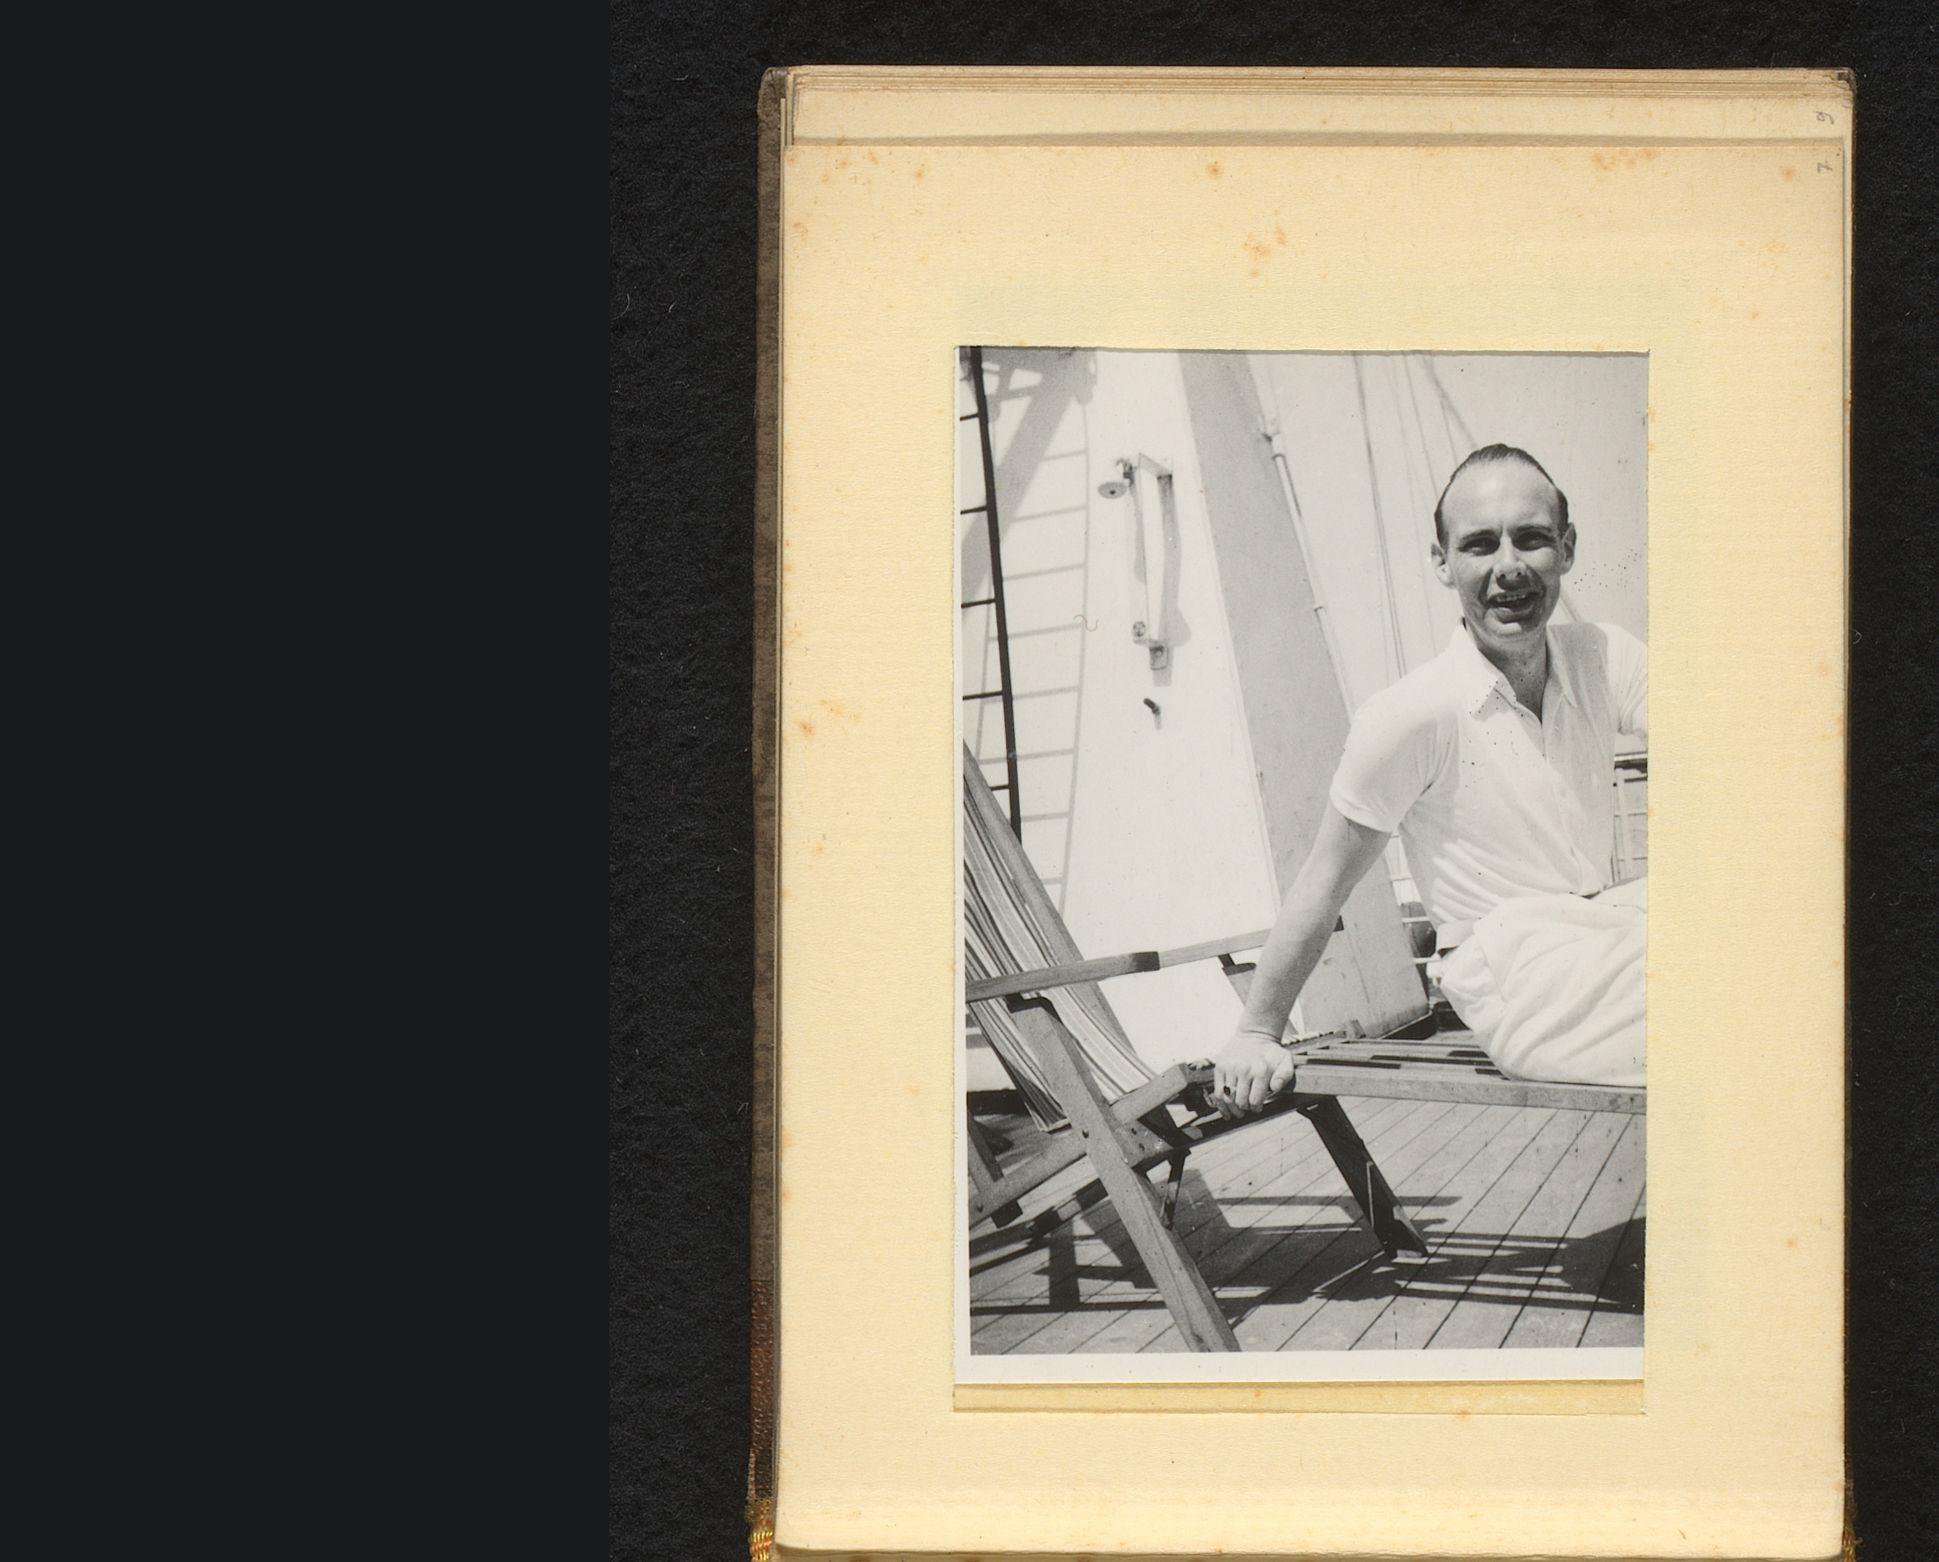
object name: photograph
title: Man aan boord van een schip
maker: norbert van den berg (1901-1972)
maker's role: amateurfotograaf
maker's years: 1901-1972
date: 1935-1950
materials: paper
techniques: gelatin silver print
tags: ships (in general), passengers ~ ship